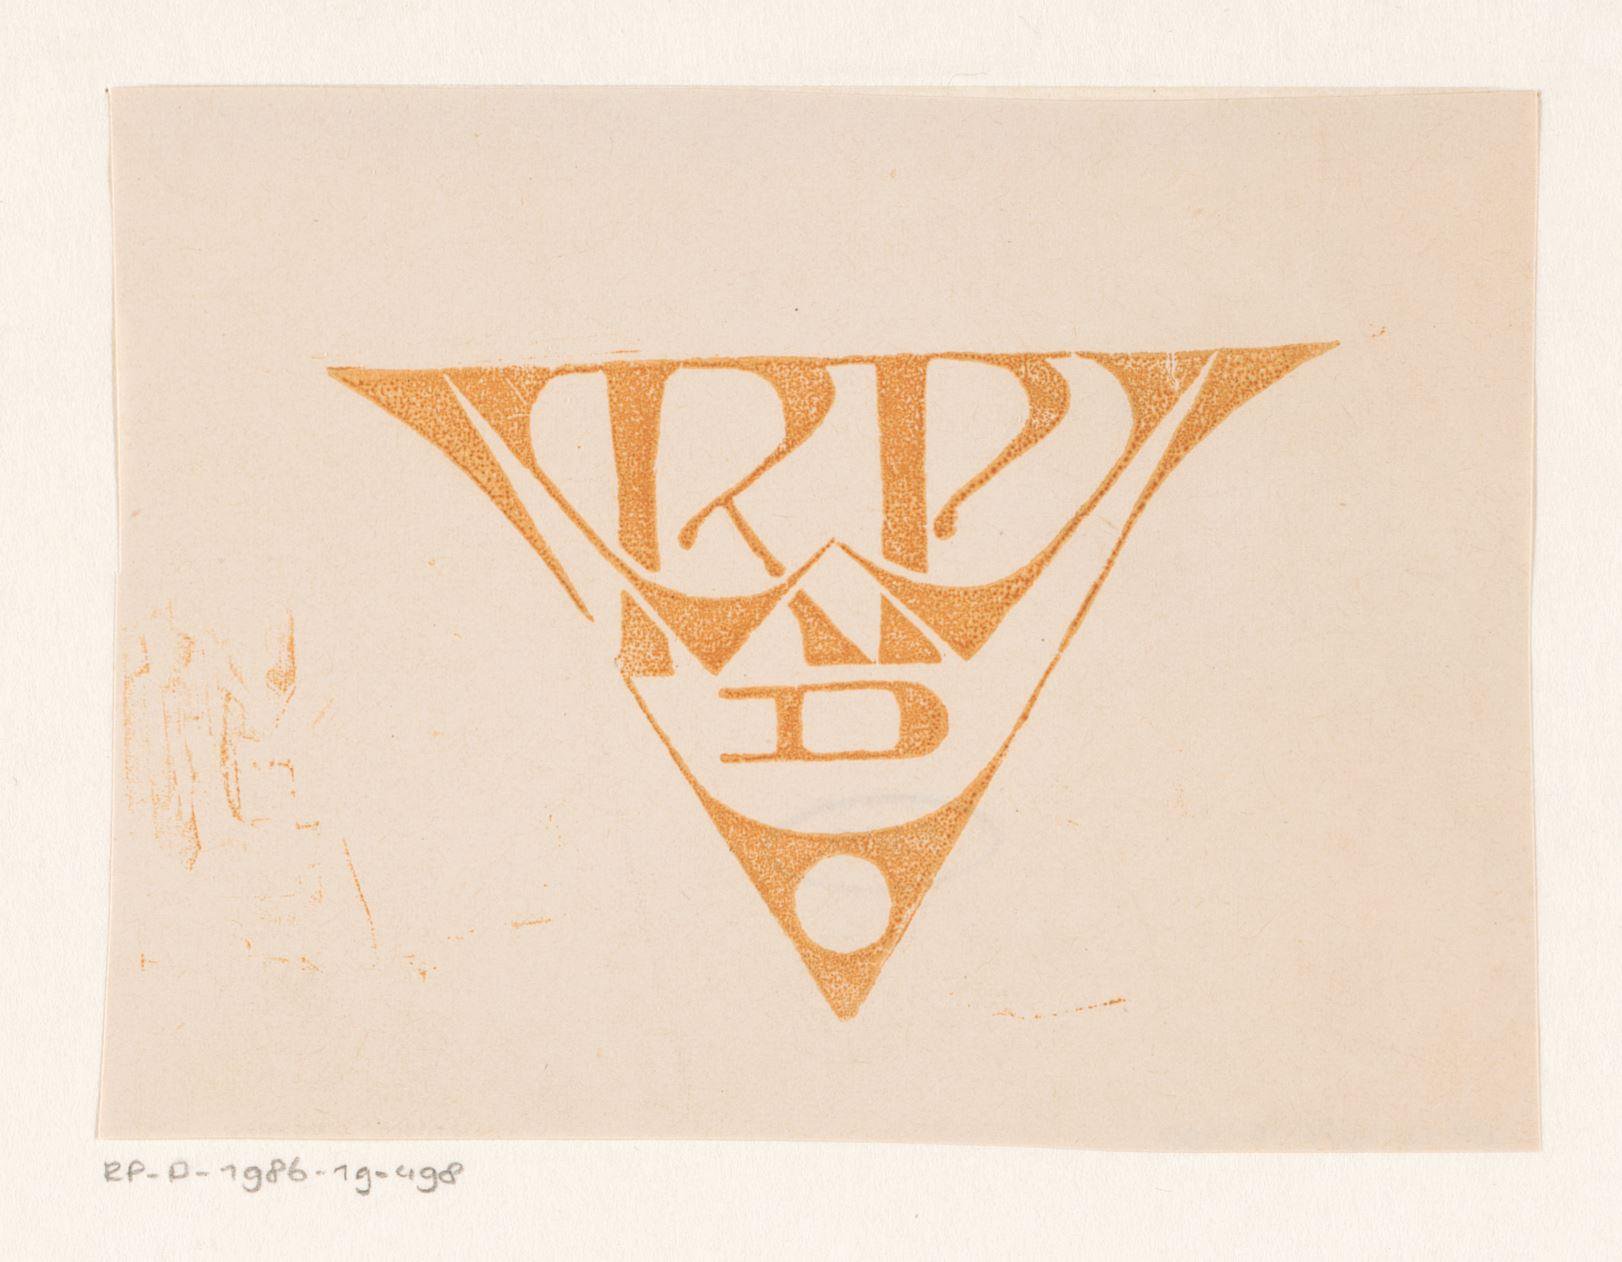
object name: photomechanical print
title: Vignet met monogram RWPdV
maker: reinier willem petrus de vries (1874-1953)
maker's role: draughtsman, print maker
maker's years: 1874-1953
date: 1884-1952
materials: paper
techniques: printing block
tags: magic mathematical figures; magic numbers, words, monograms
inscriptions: collector's mark: ‘R:MVS.’